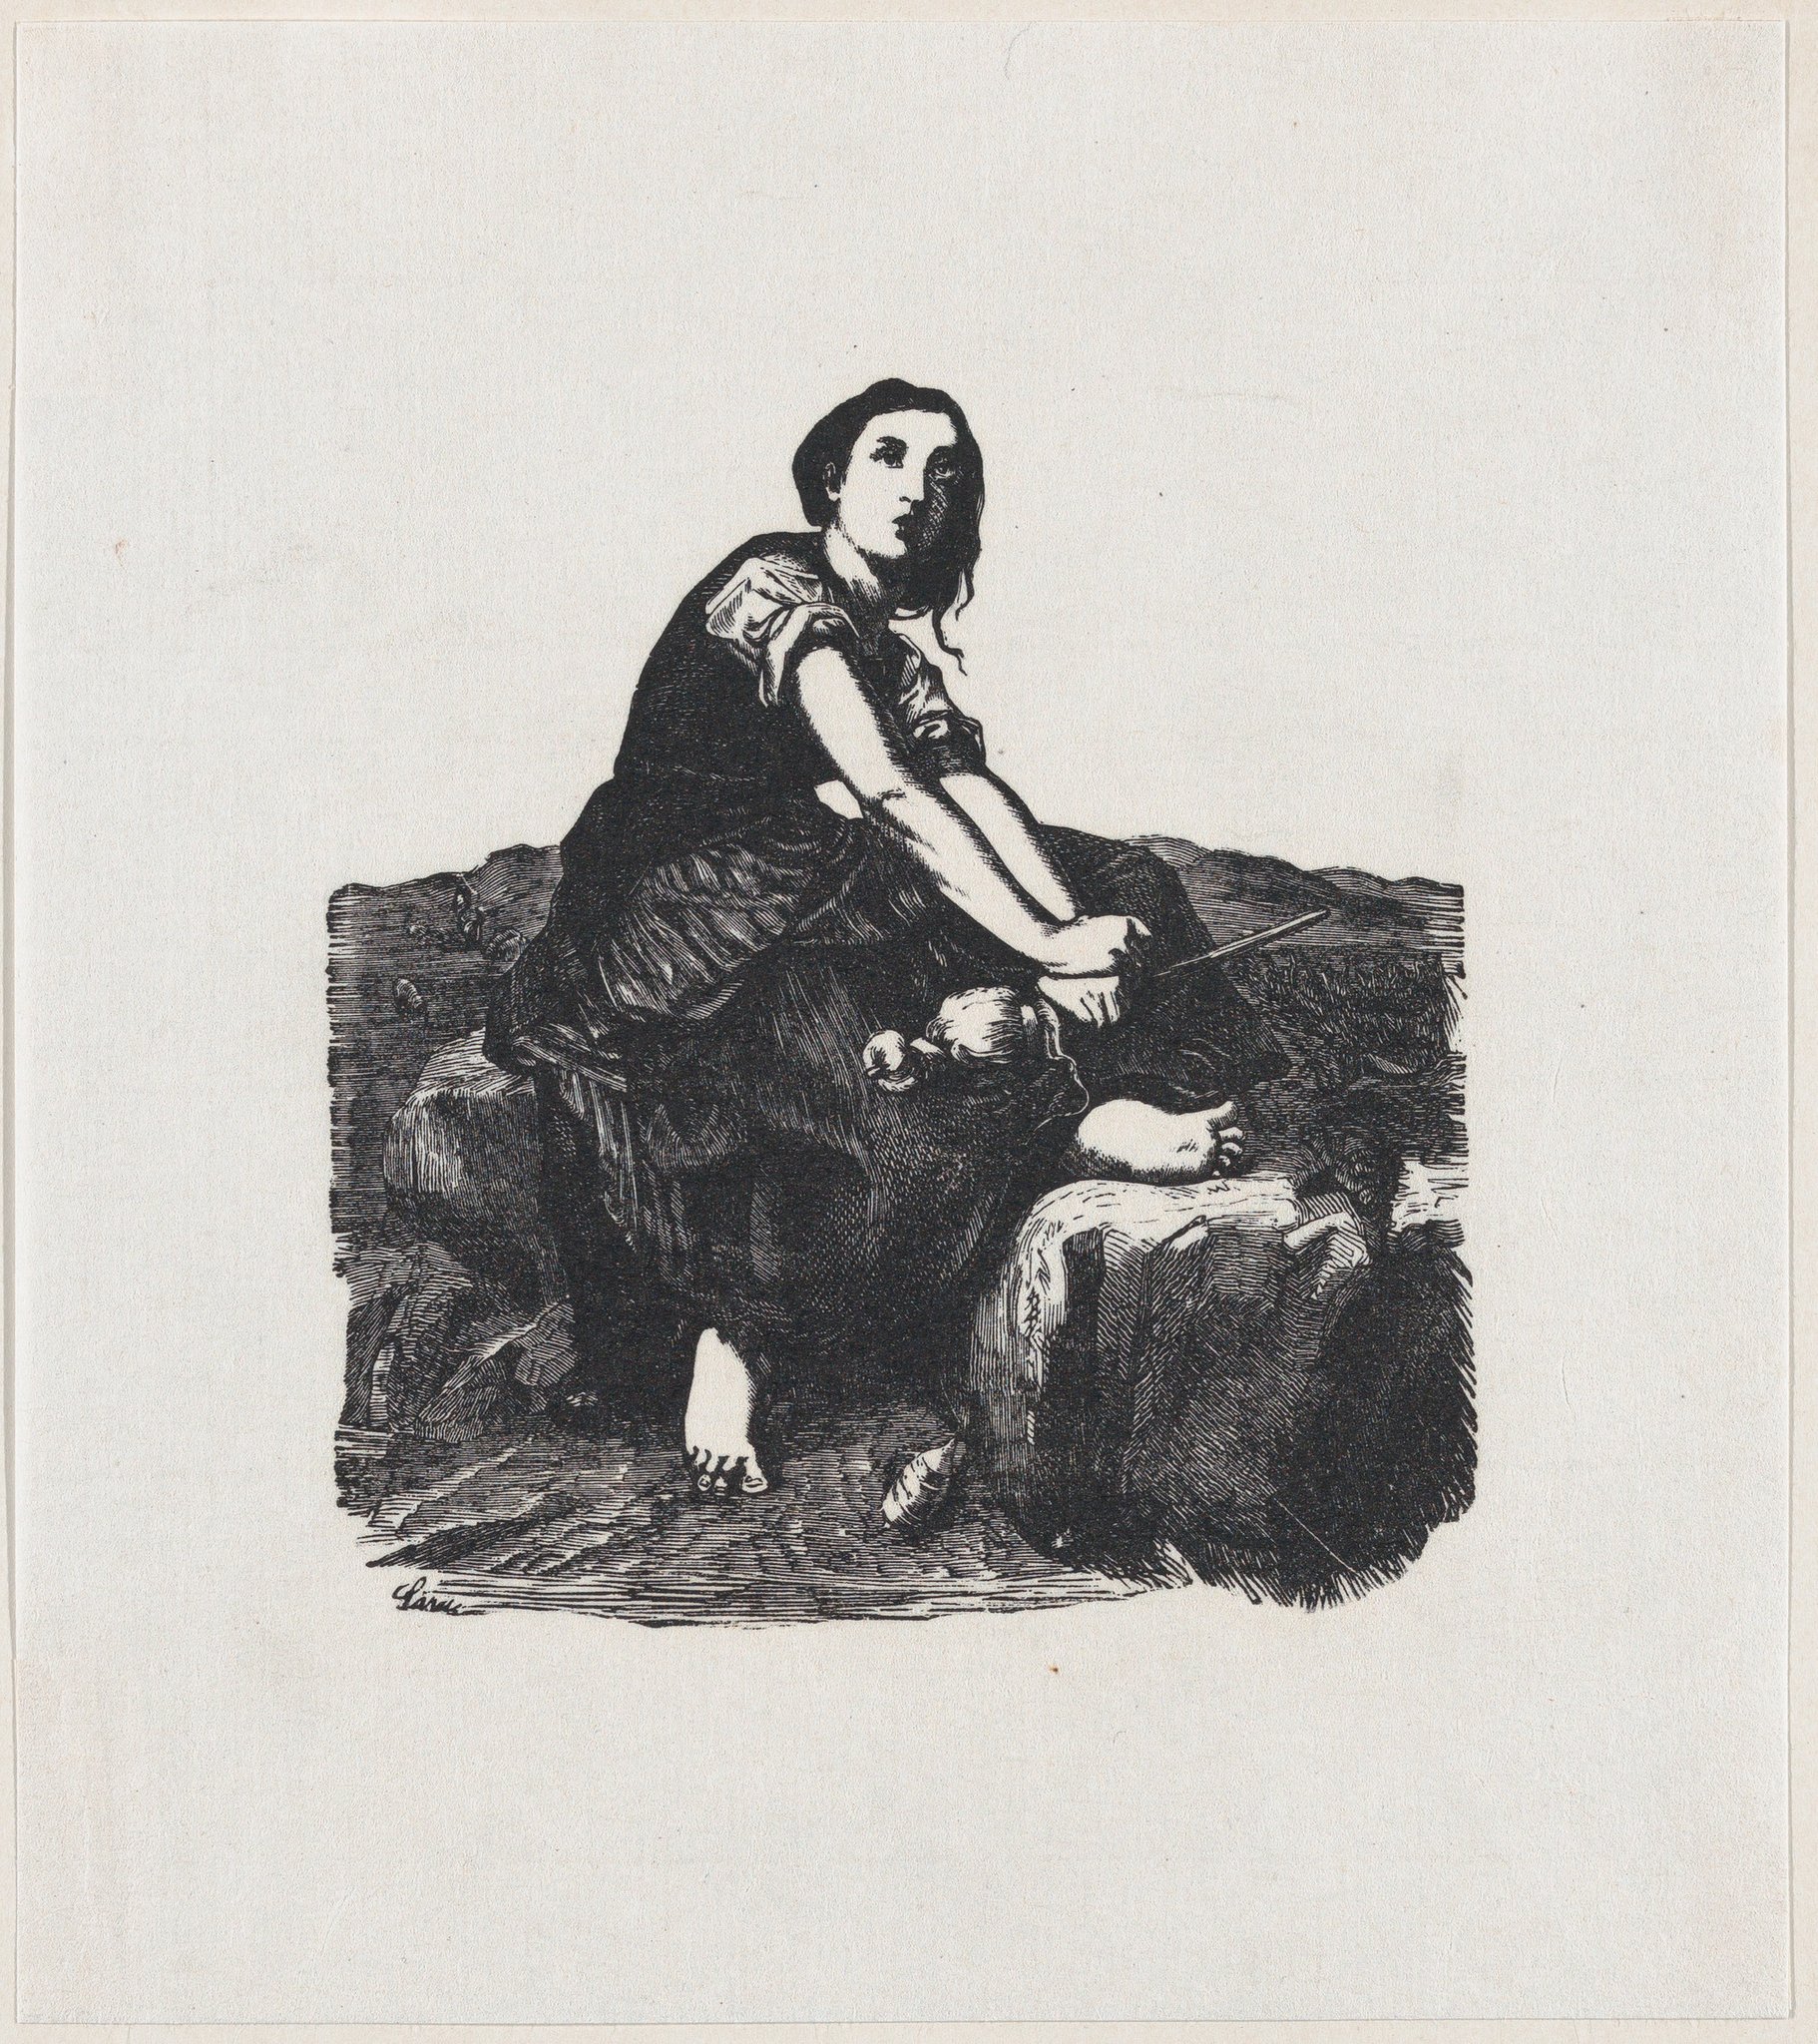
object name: print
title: Girl seated on a rock holding a distaff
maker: anonymous, mexican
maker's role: artist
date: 1801-1900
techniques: engraving